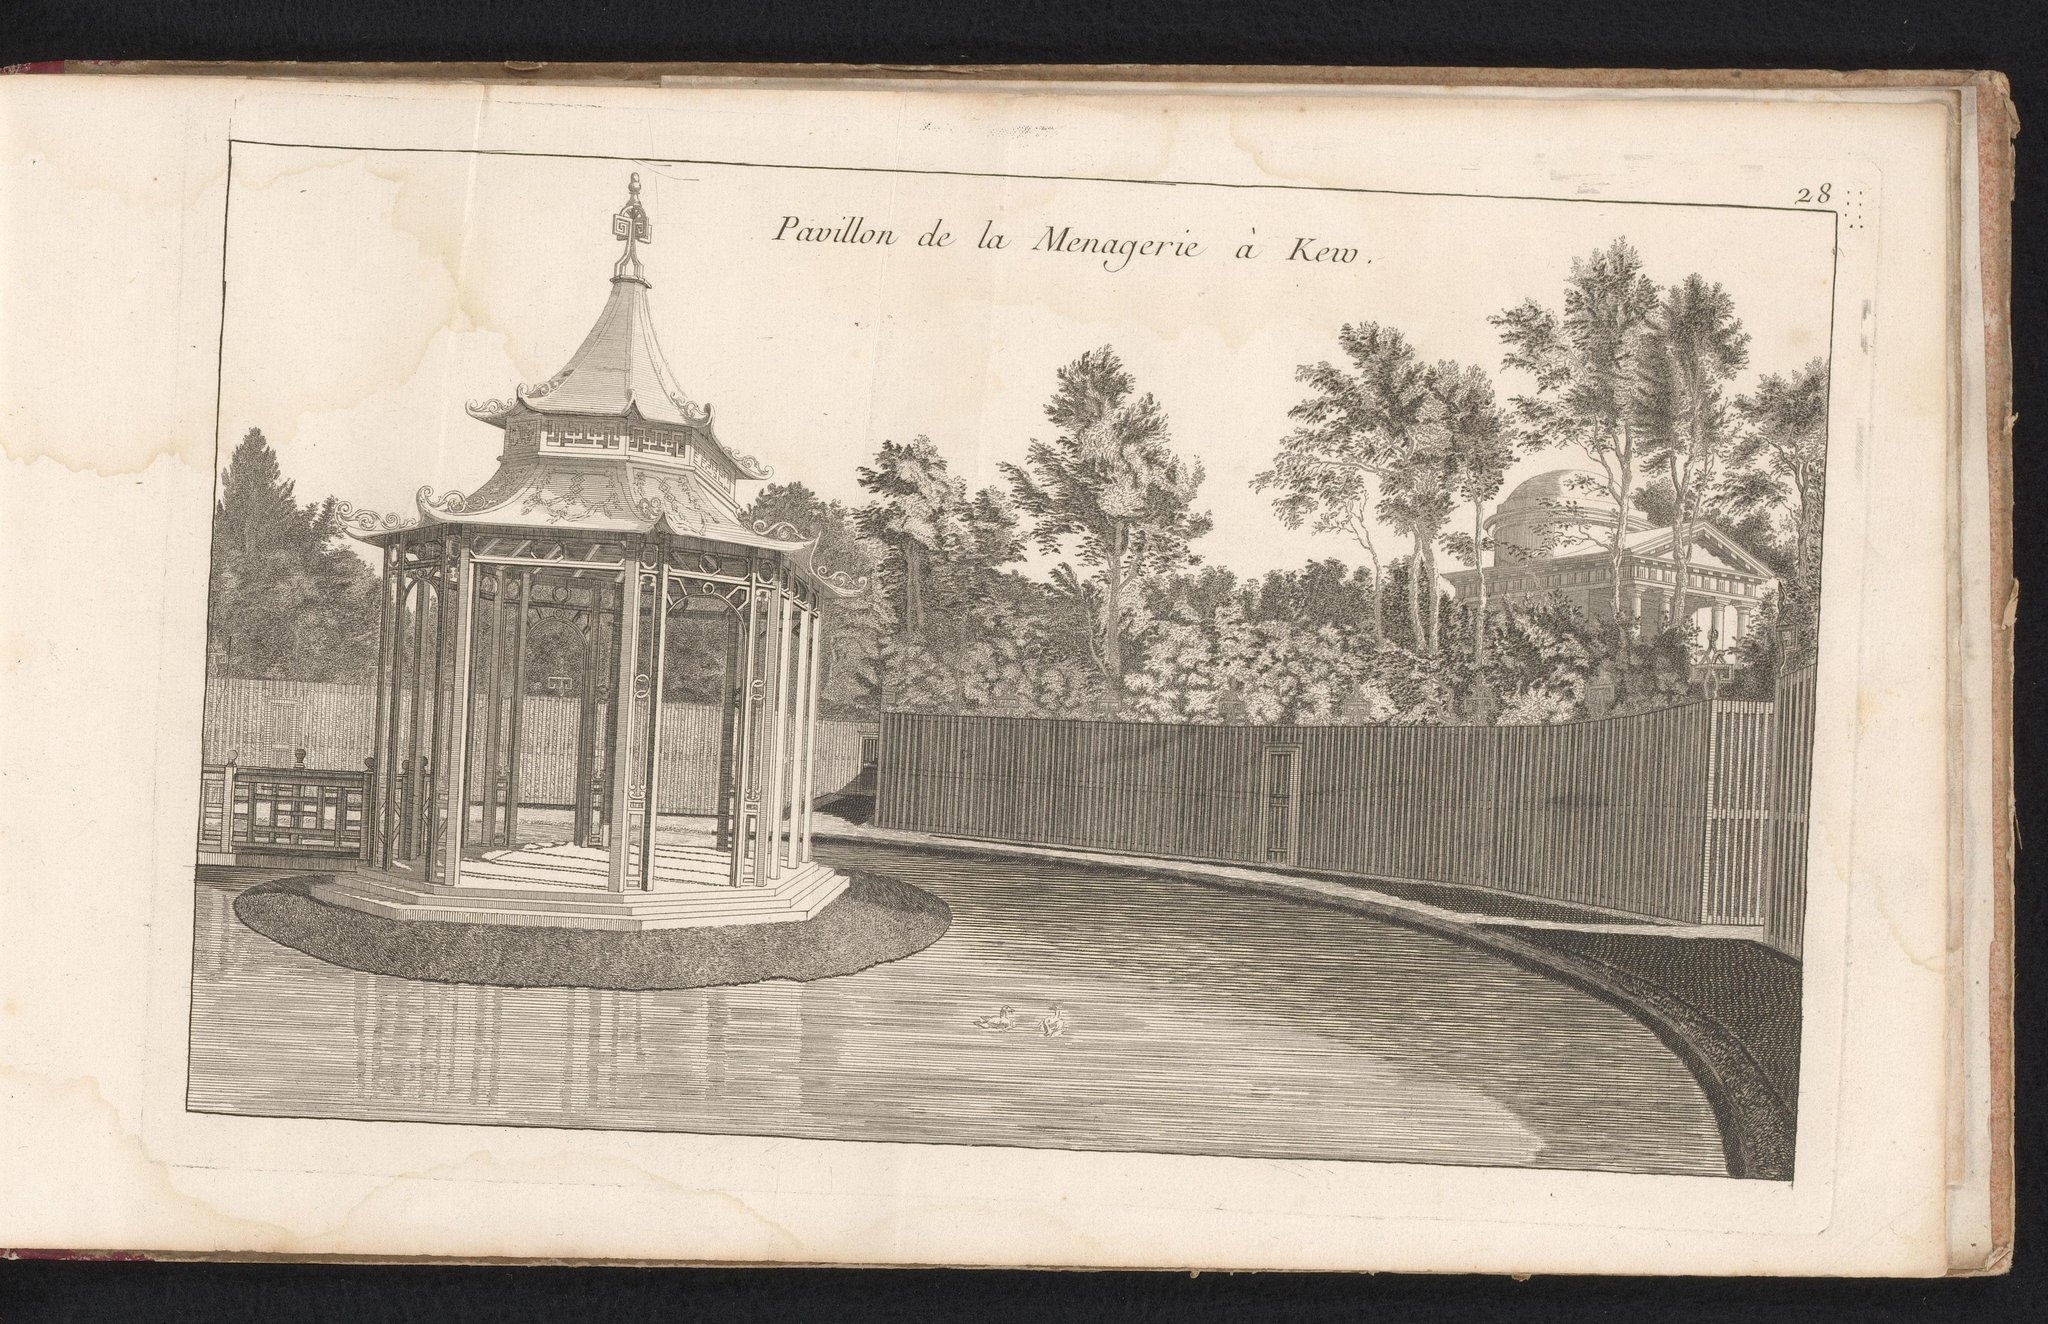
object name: album leaf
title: Landschapstuinen in Chinees-Engelse stijl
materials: paper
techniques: engraving, etching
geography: paris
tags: garden buildings, garden pond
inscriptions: collector's mark: Lugt 2760, collector's mark: Lugt 2228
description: De serie 'Jardins anglo-chinois à la mode' verscheen in totaal in 21 zogeheten 'cahiers' (afleveringen). De huidige prent komt uit het achtste 'cahier'. Het Rijksmuseum Amsterdam bezit drie banden met daarin in totaal zes 'cahiers' van deze reeks. In de documentatie wordt verwezen naar een in de bibliotheek van het Rijksmuseum Amsterdam aanwezige facsimile van het complete werk.